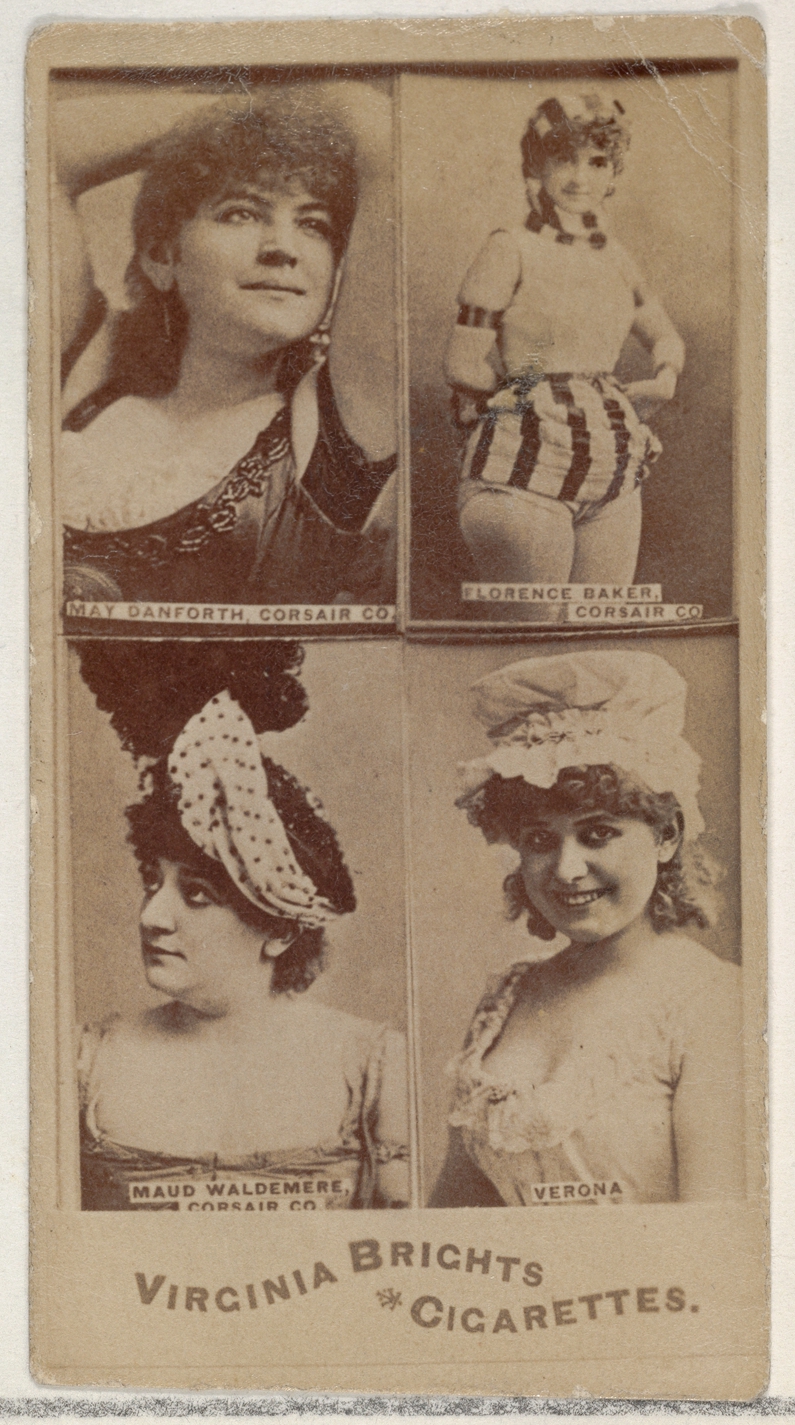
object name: photograph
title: May Danforth, Corsair Co./ Florence Baker, Corsair Co./ Maud Waldemere, Corsair Co./ Verona, from the Actors and Actresses series (N45, Type 4) for Virginia Brights Cigarettes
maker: allen & ginter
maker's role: publisher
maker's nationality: american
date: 1888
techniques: albumen silver print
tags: portraits,women,actresses